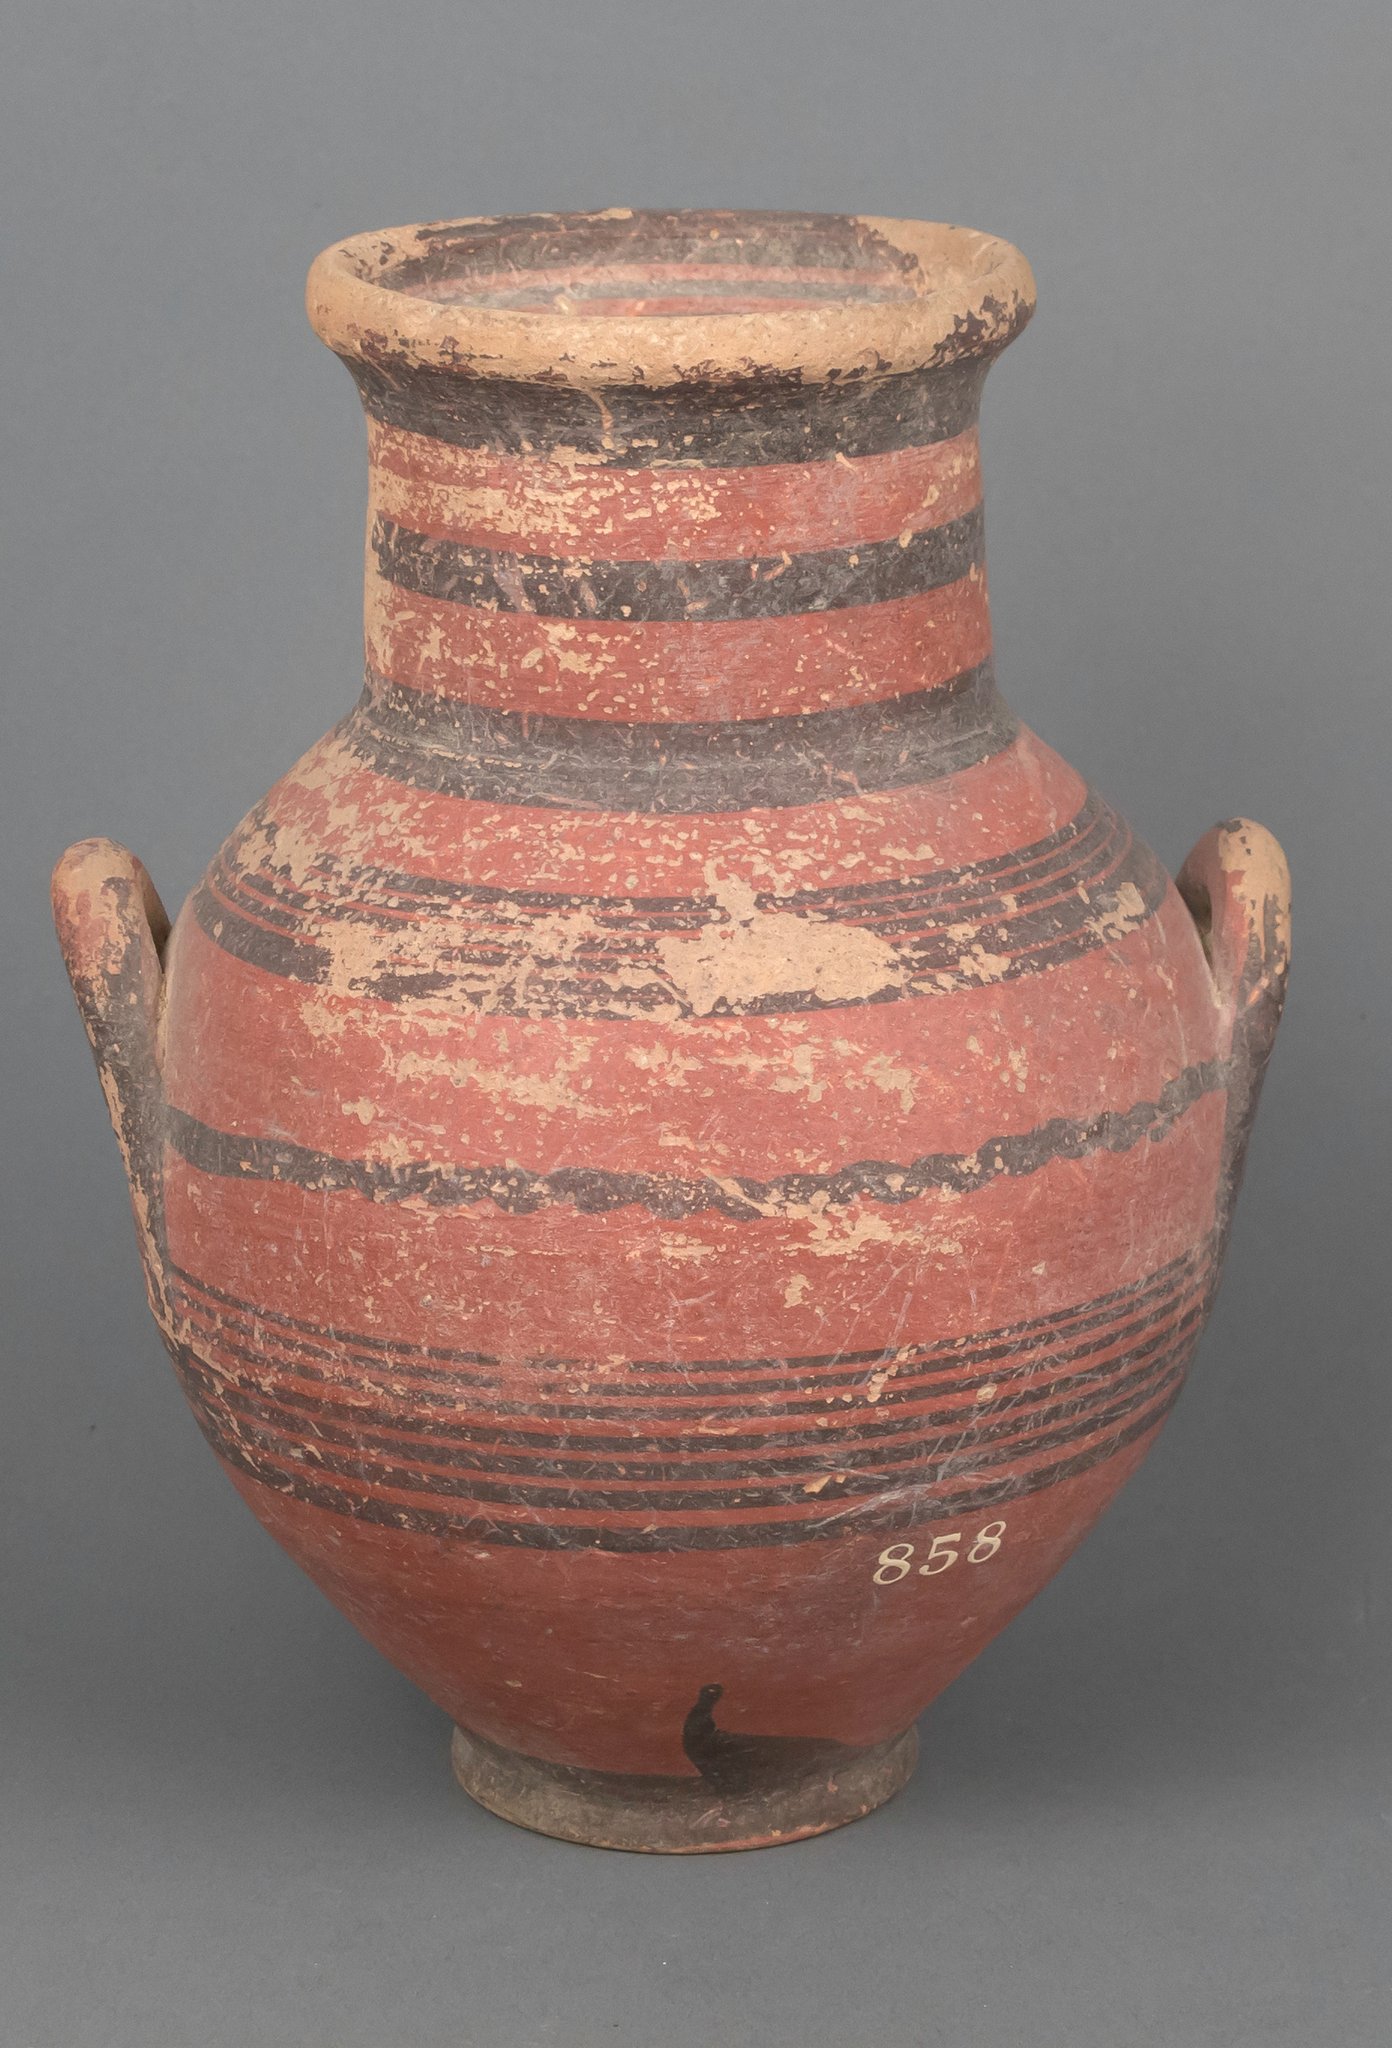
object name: amphora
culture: cypriot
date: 1125-1050 BCE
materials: terracotta